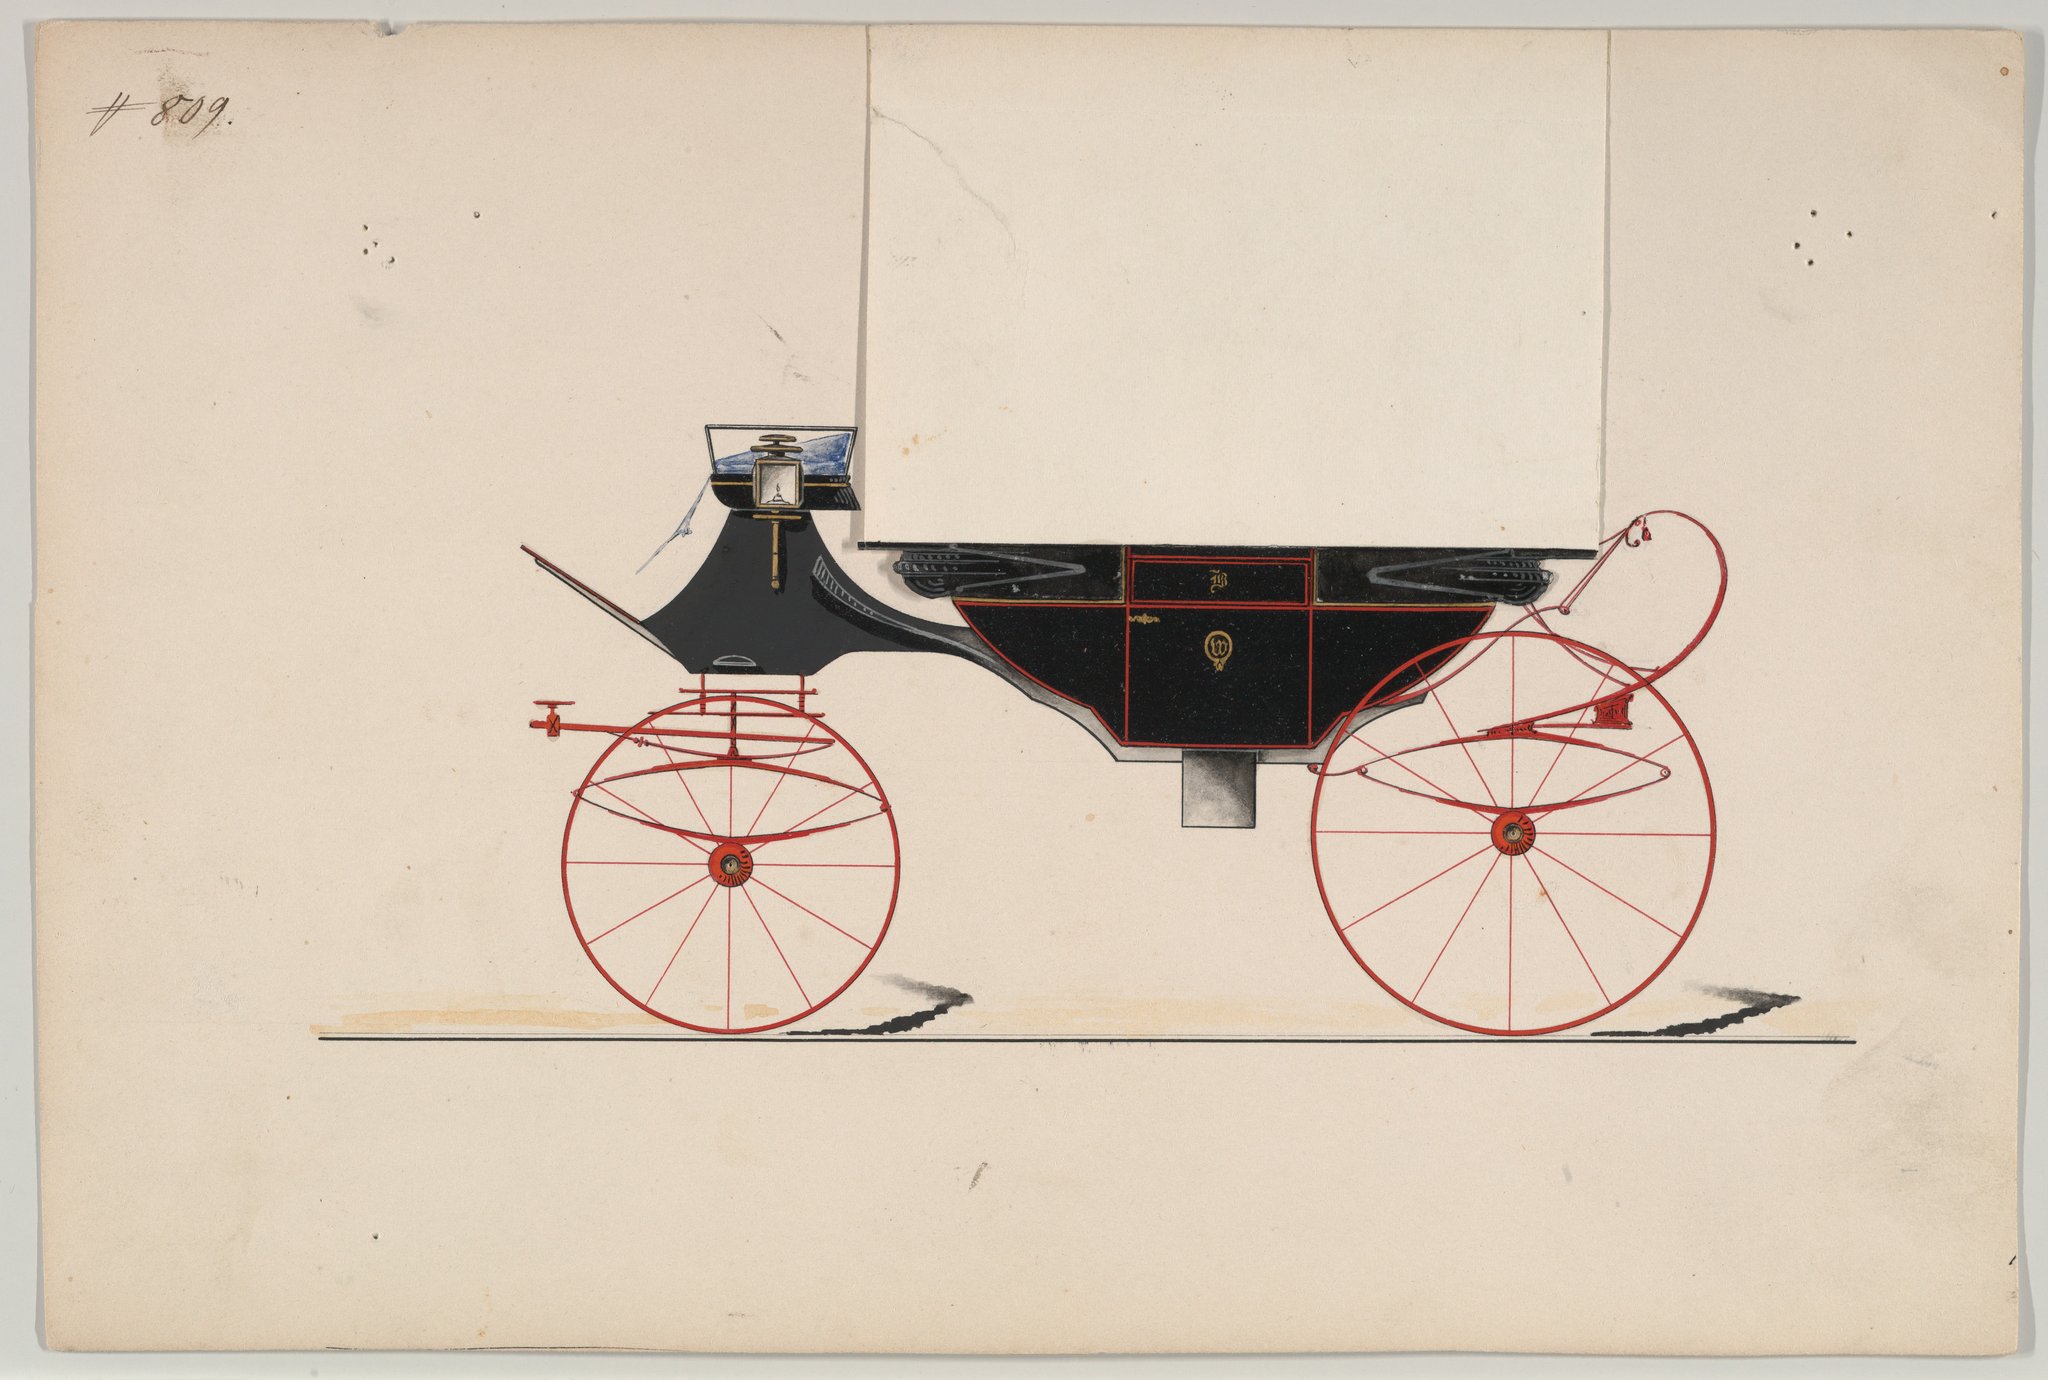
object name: drawing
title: Landau #809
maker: brewster & co.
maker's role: manufacturer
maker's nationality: american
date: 1850-1870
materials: gouache, gum arabic, ink, watercolor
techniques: pen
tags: carriages